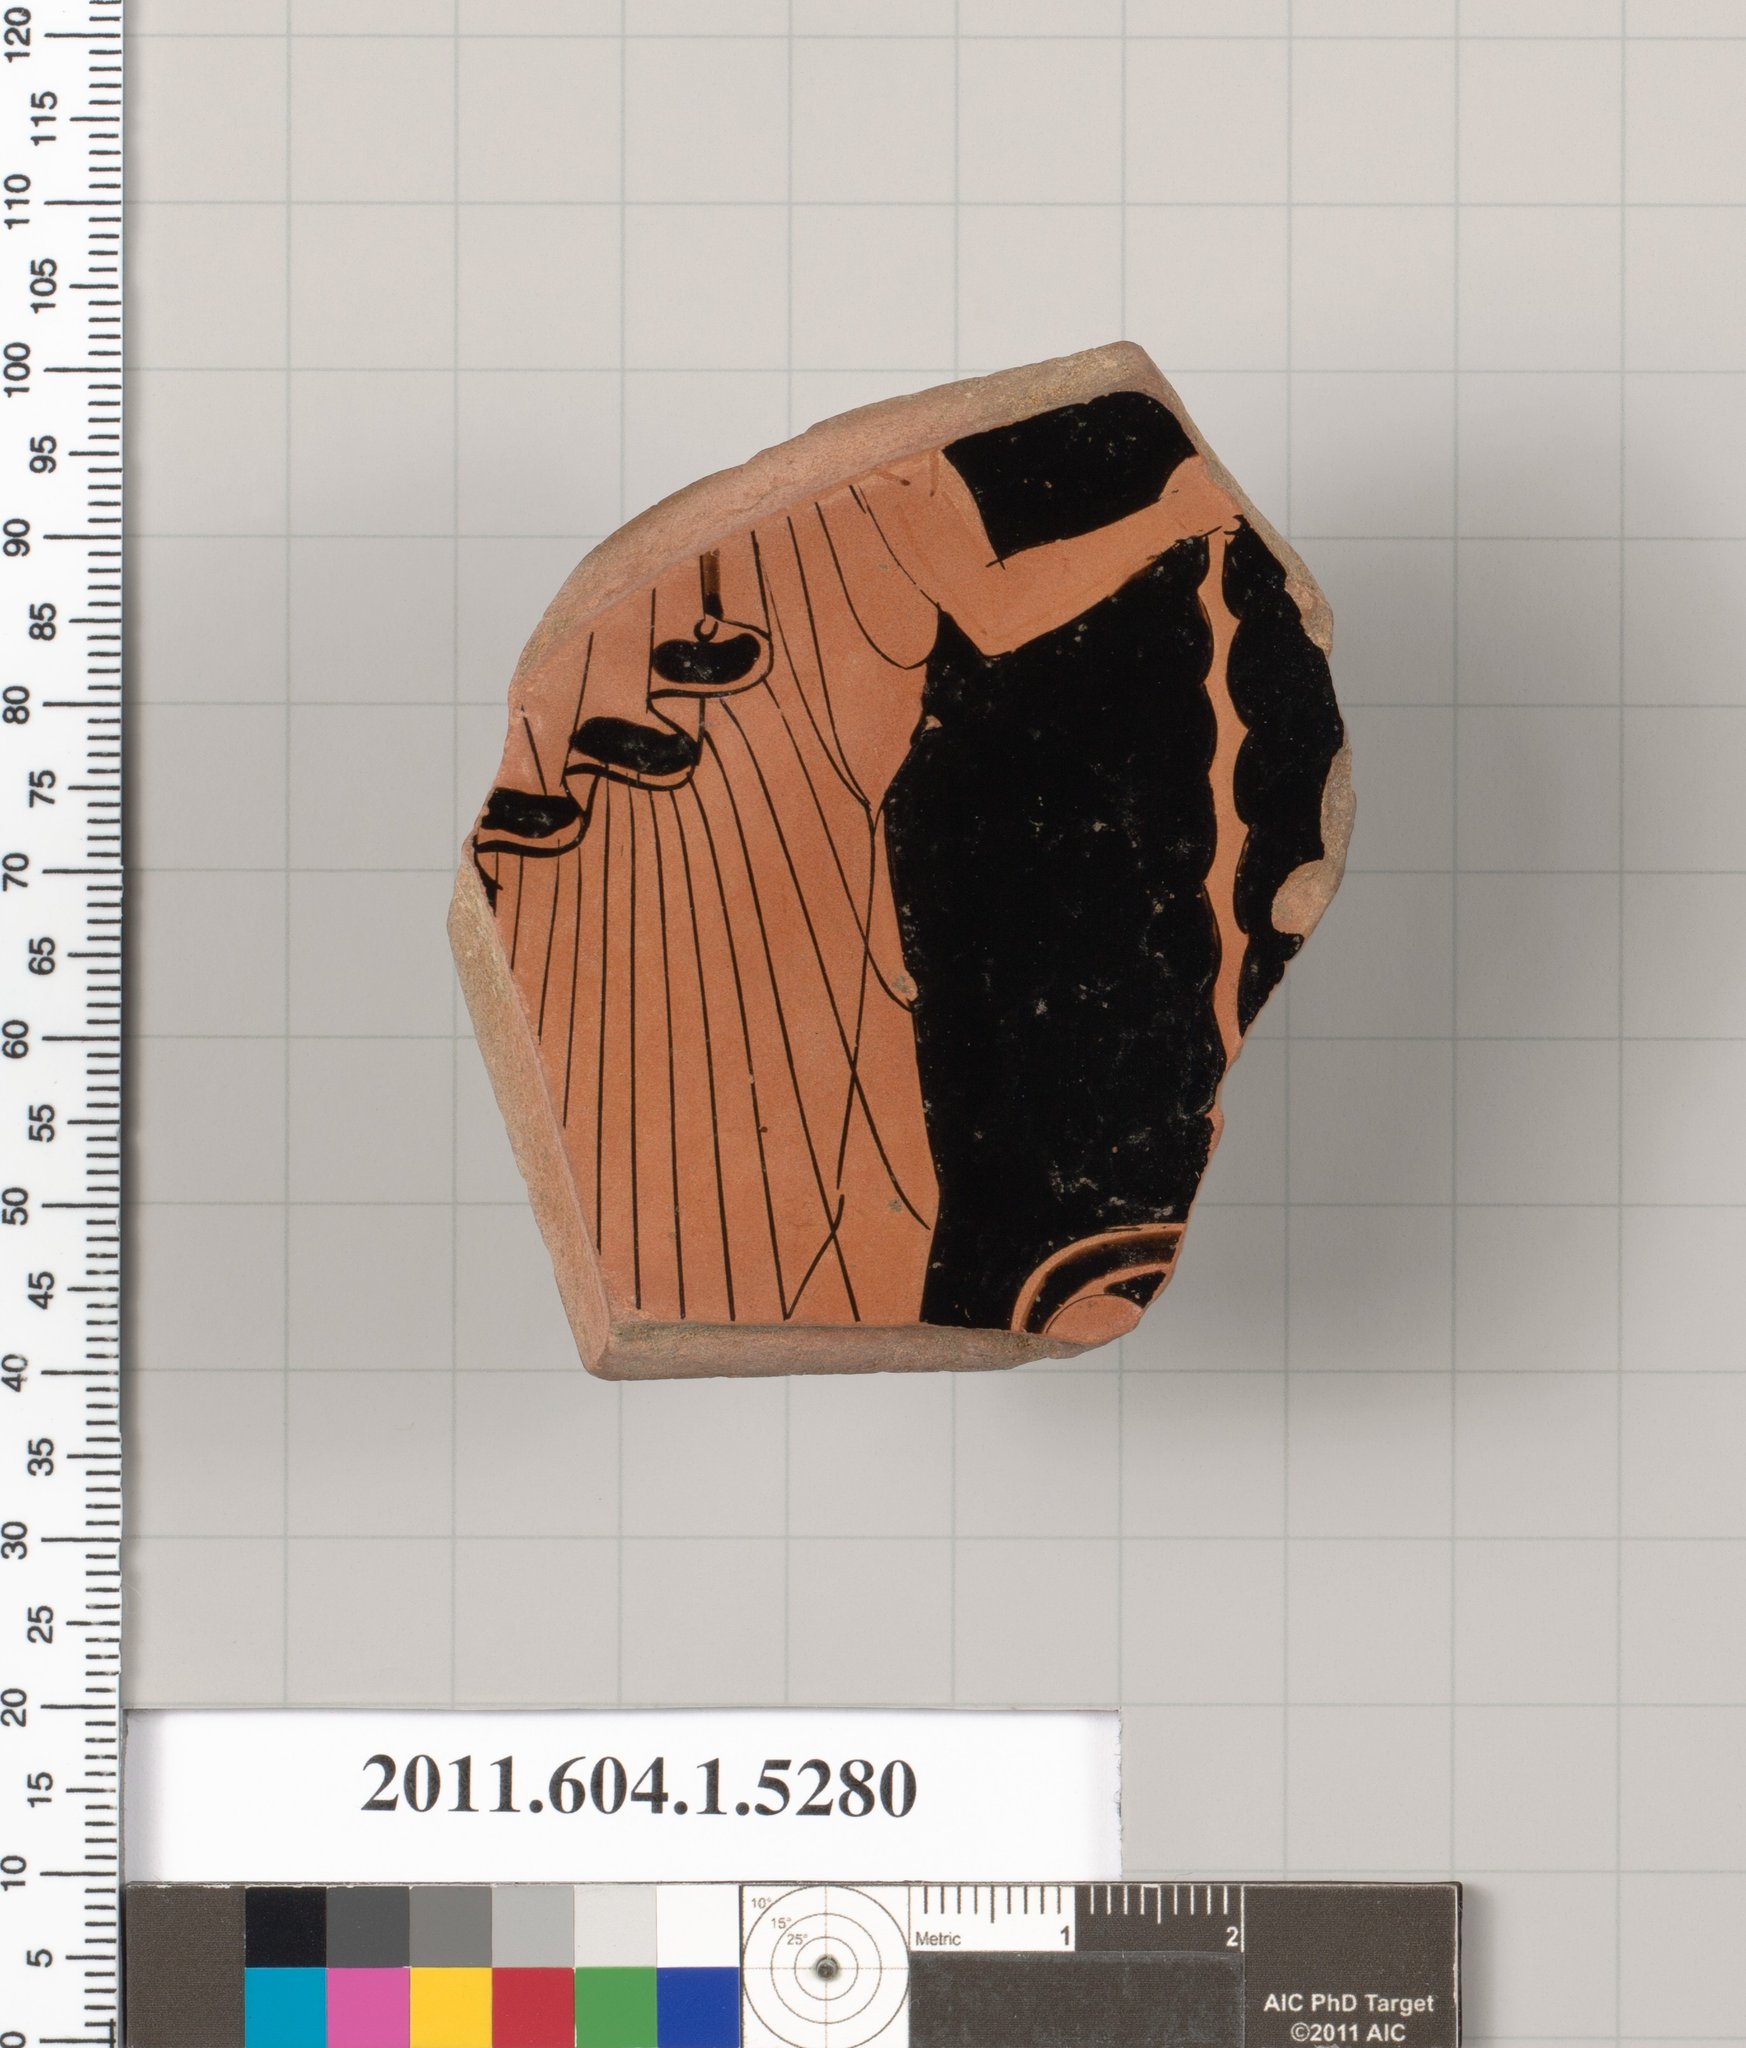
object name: kylix fragment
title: Terracotta fragment of a kylix (drinking cup)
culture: greek, attic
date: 490-470 BCE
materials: terracotta